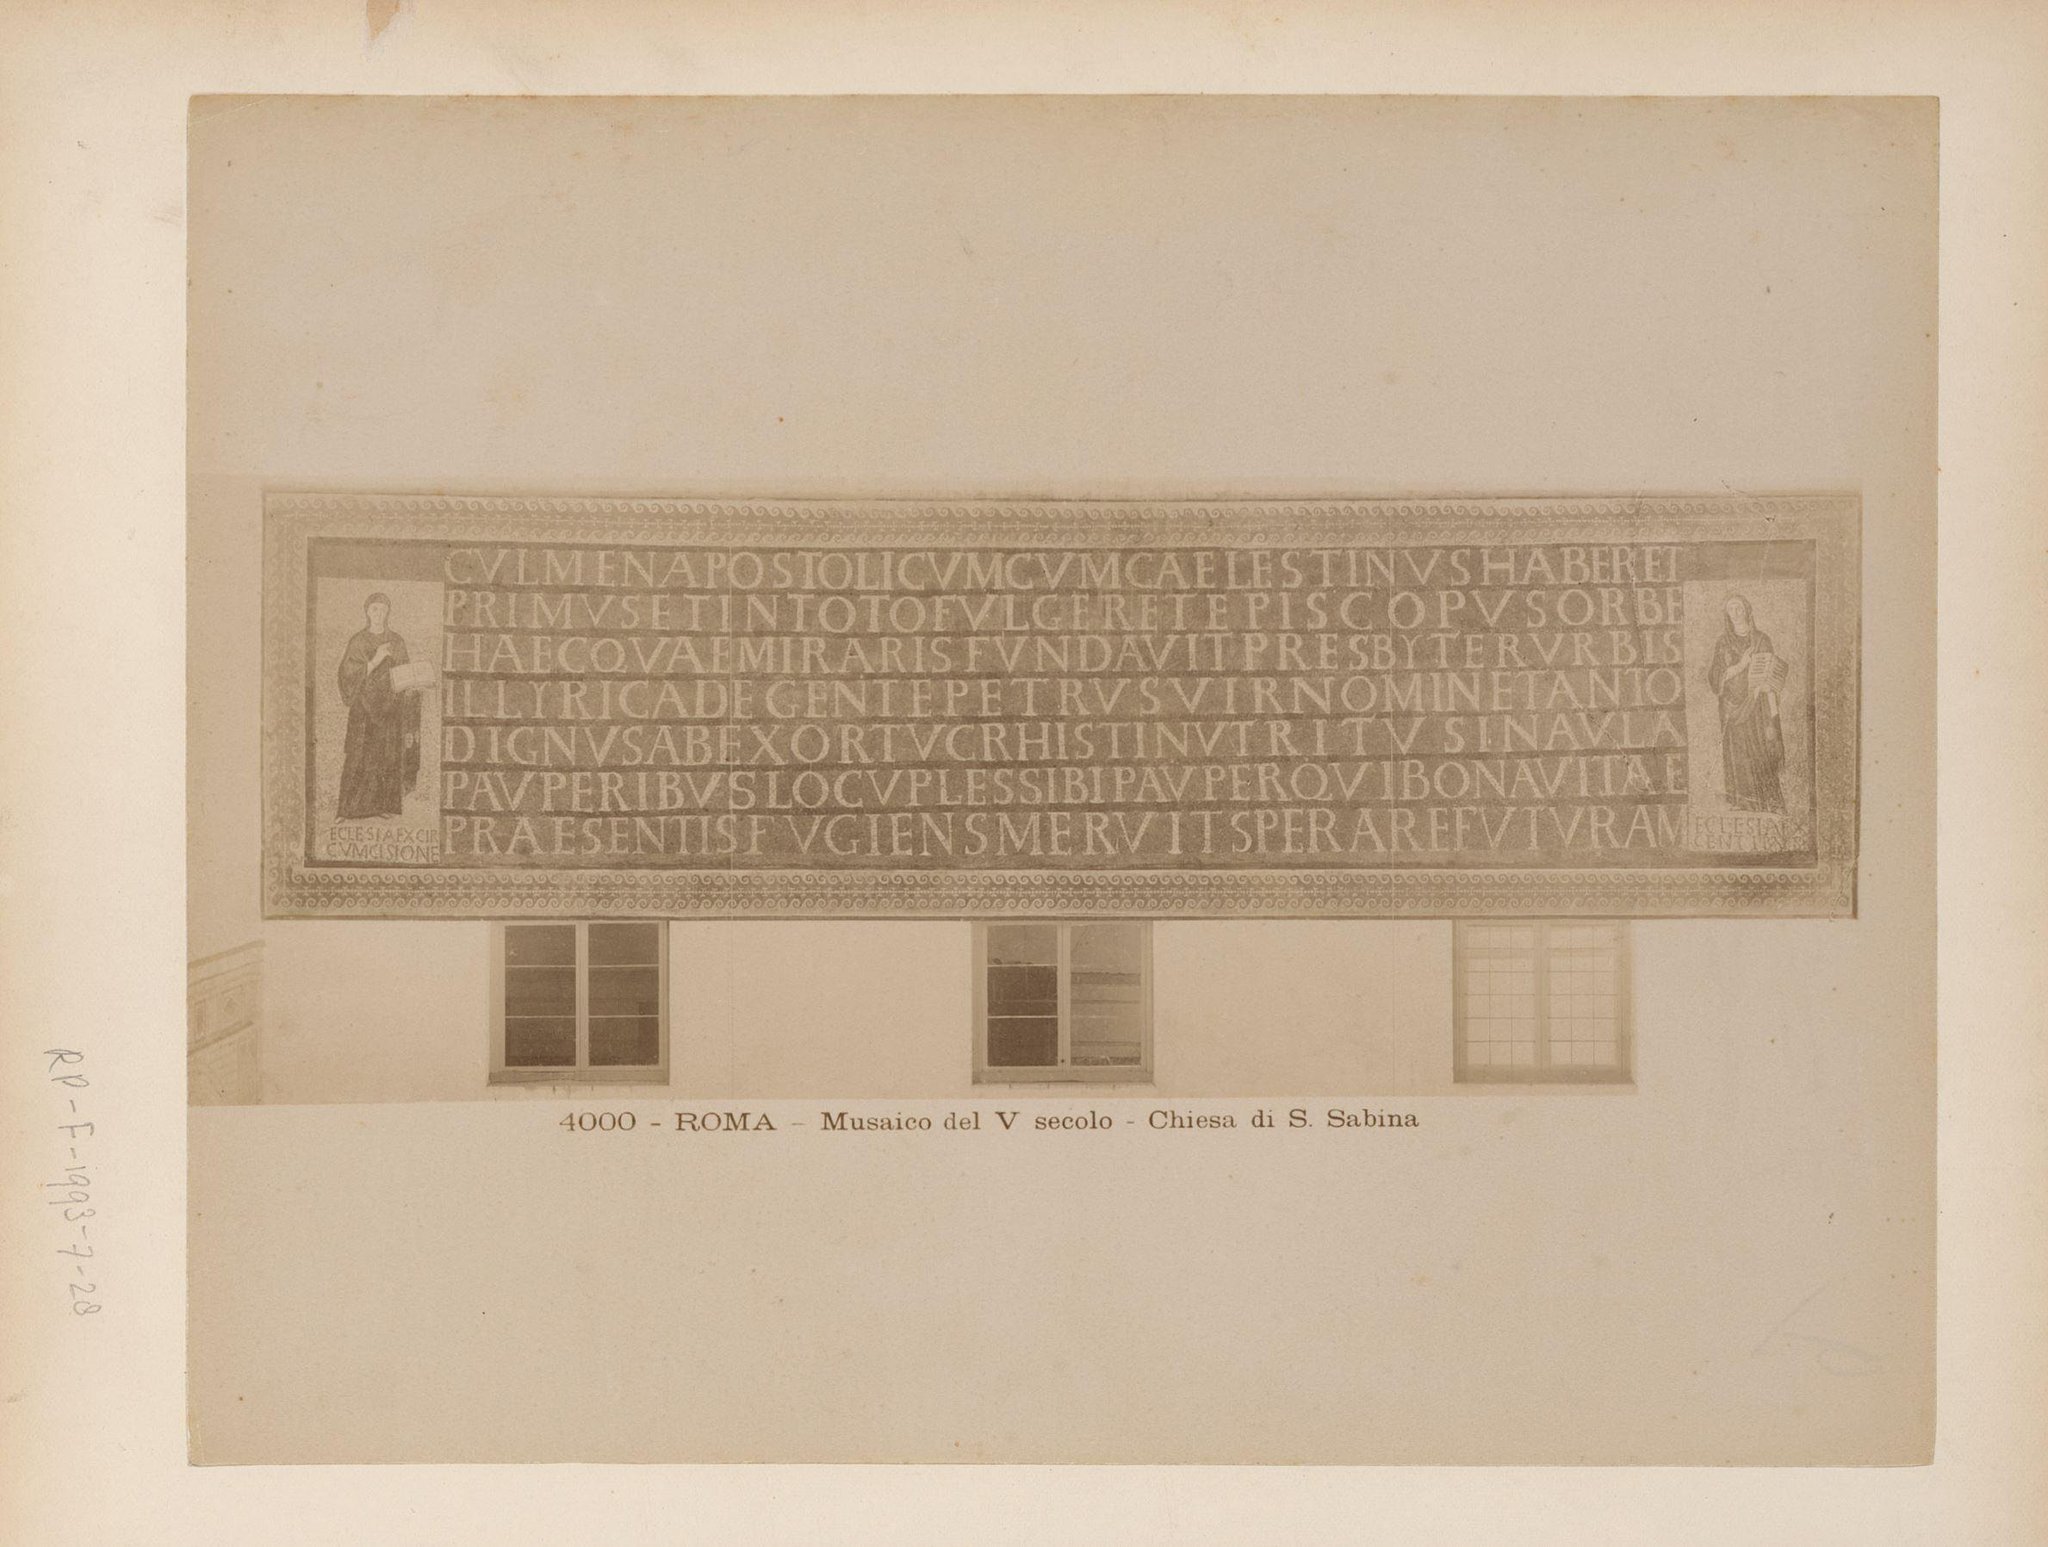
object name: album leaf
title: Fotoreproductie van mozaïek uit de vijfde eeuw in de Santa Sabina te Rome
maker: james anderson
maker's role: fotograaf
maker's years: 1813-1877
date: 1857-1875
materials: paper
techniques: albumen print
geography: santa sabina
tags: art and the public; styles and ornaments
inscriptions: inscription: ‘4000 - ROMA - Musaico del V secolo - Chiesa di S. Sabina’